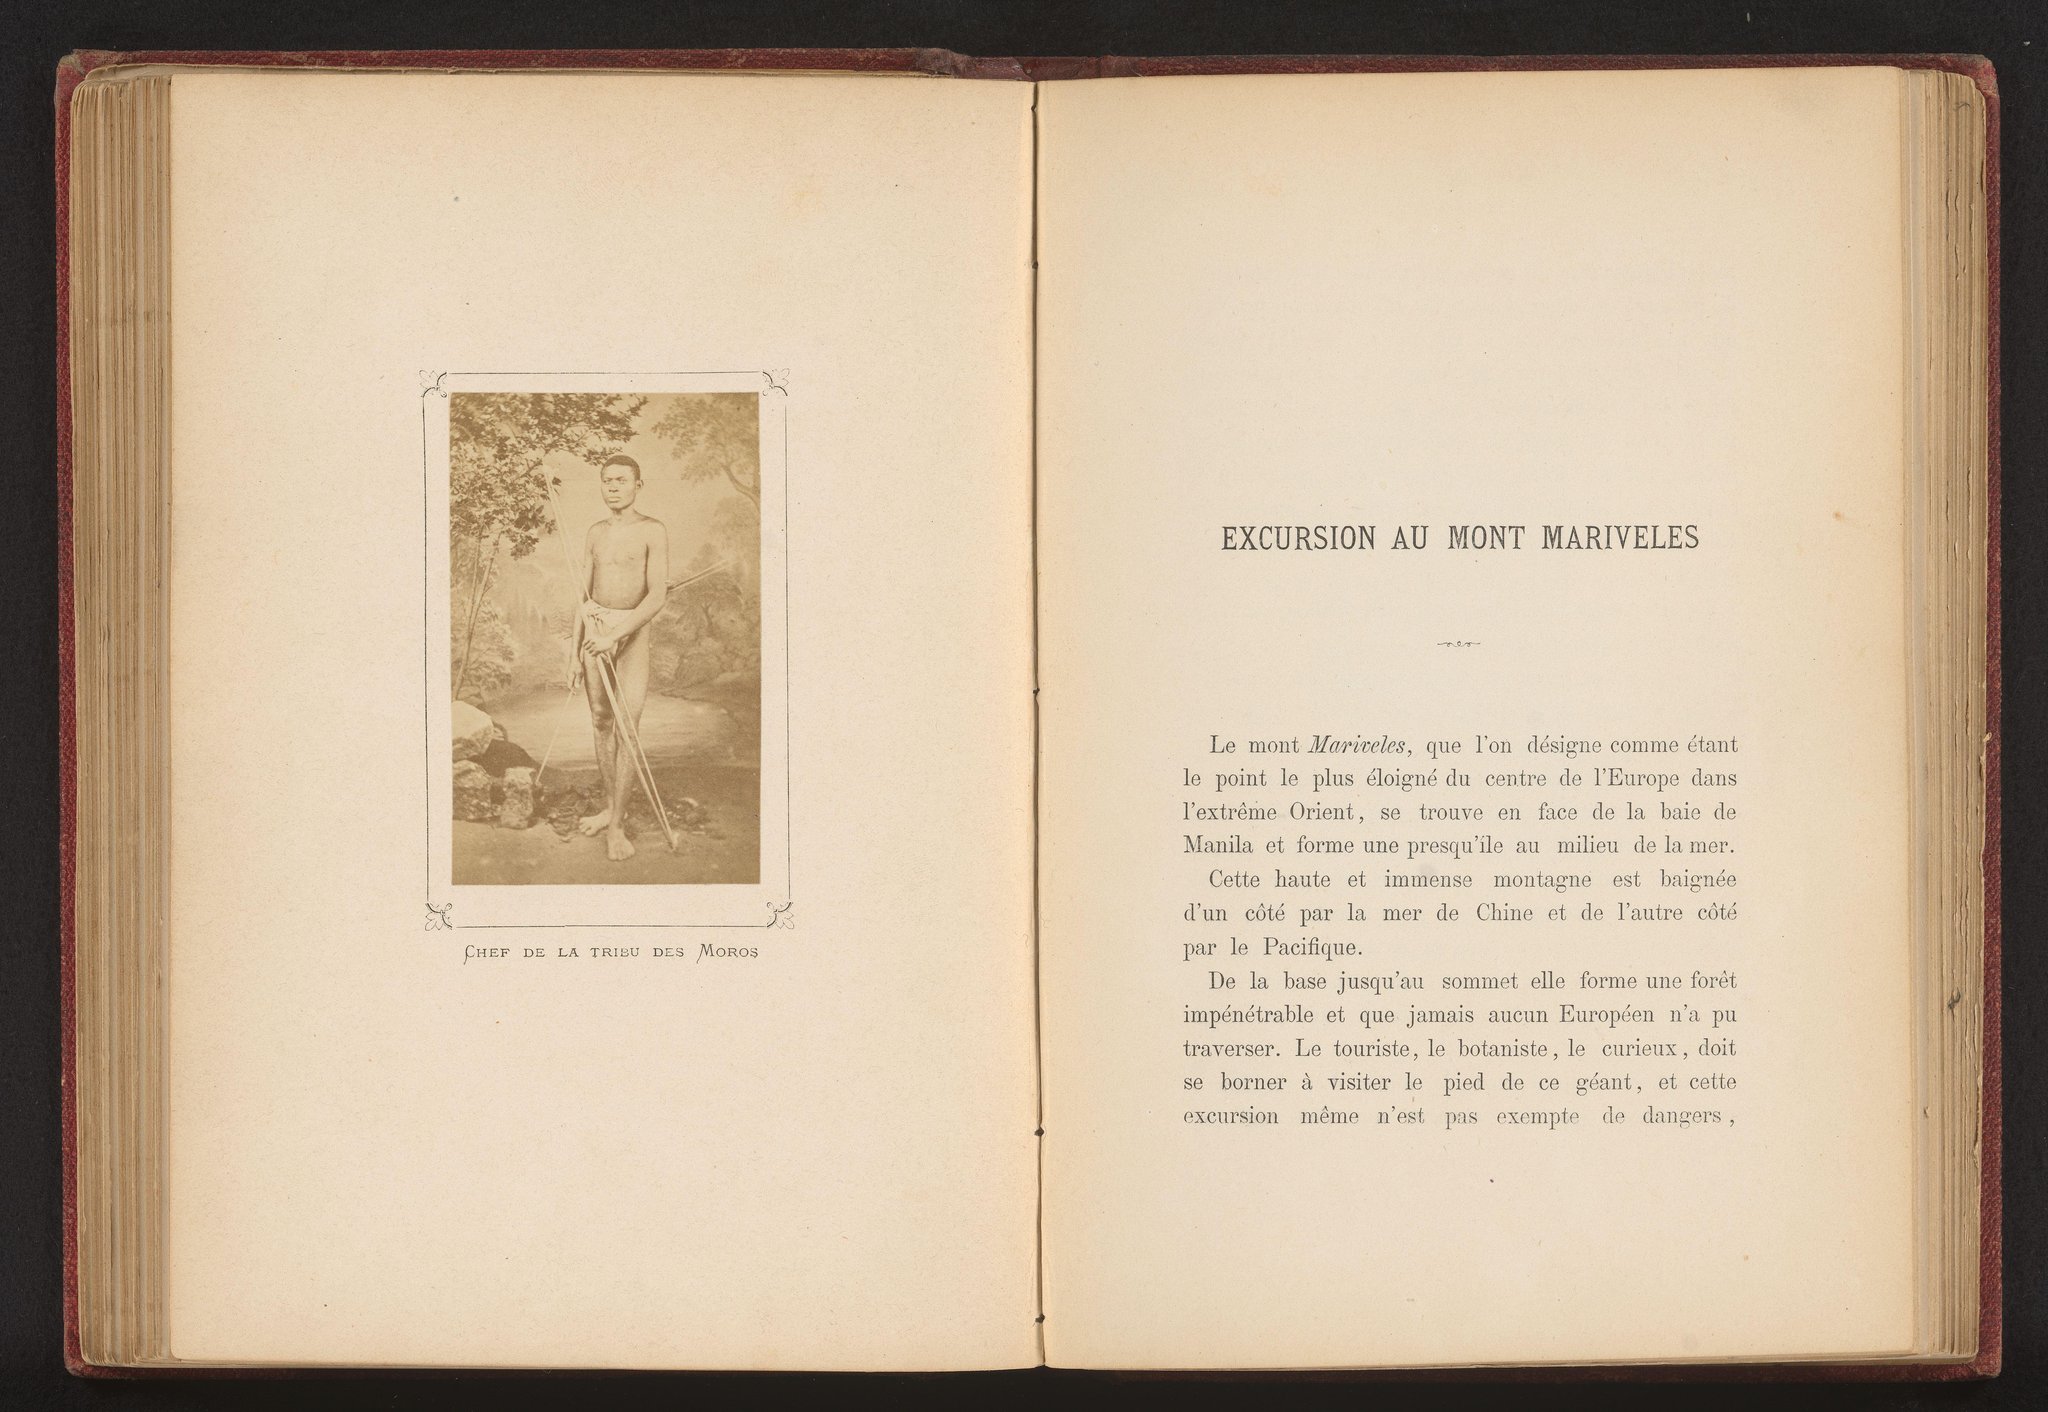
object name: page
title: Chef de la tribu des Moros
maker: Anonymous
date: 1865-1875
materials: paper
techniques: albumen print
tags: historical persons